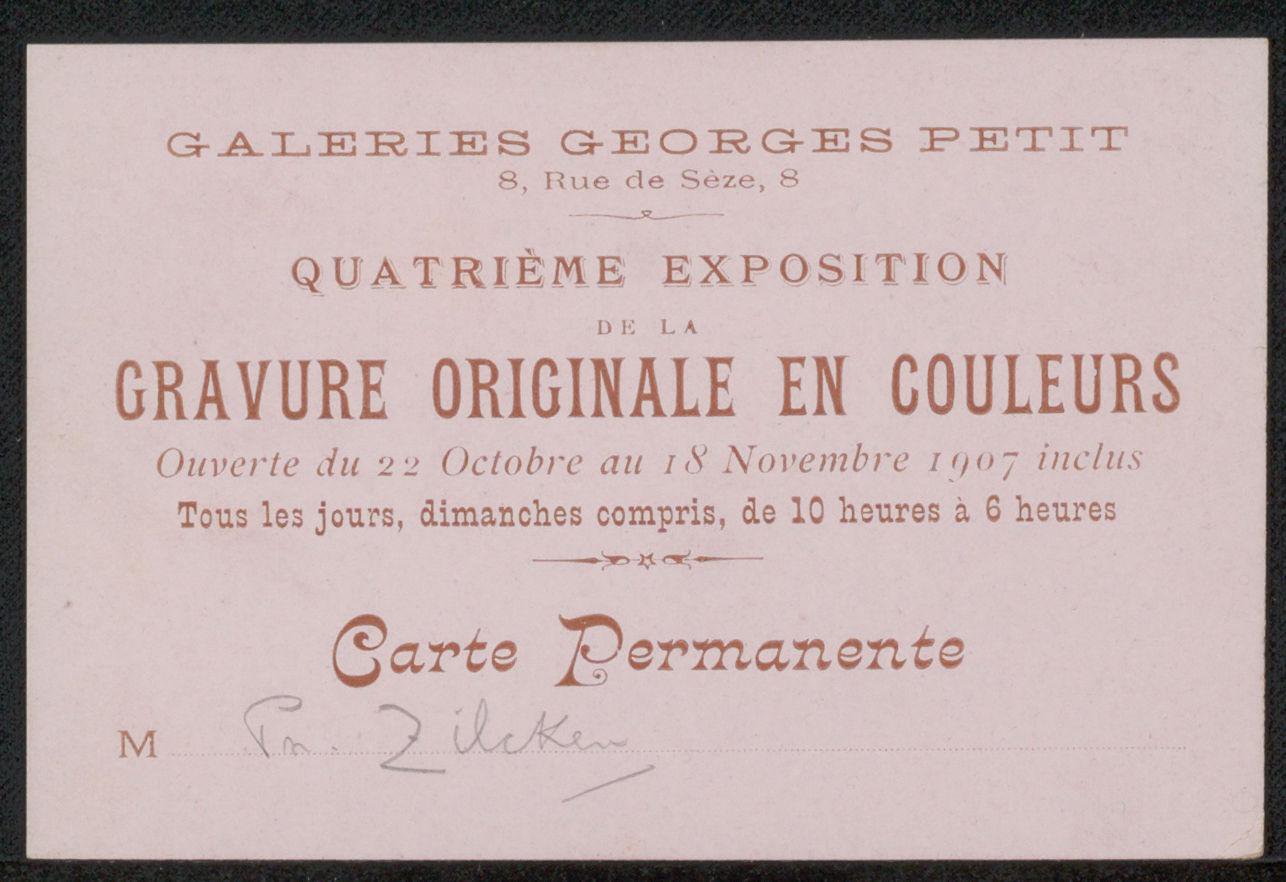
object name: admission ticket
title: Toegangskaarten aan Philip Zilcken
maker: jean françois raffaëlli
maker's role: print maker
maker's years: 1850-1924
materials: cardboard, pencil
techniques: printing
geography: paris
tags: painter, draughtsman, philip zilcken, the graphic arts, exhibition ~ art, paris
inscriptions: collector's mark: ‘RPK’